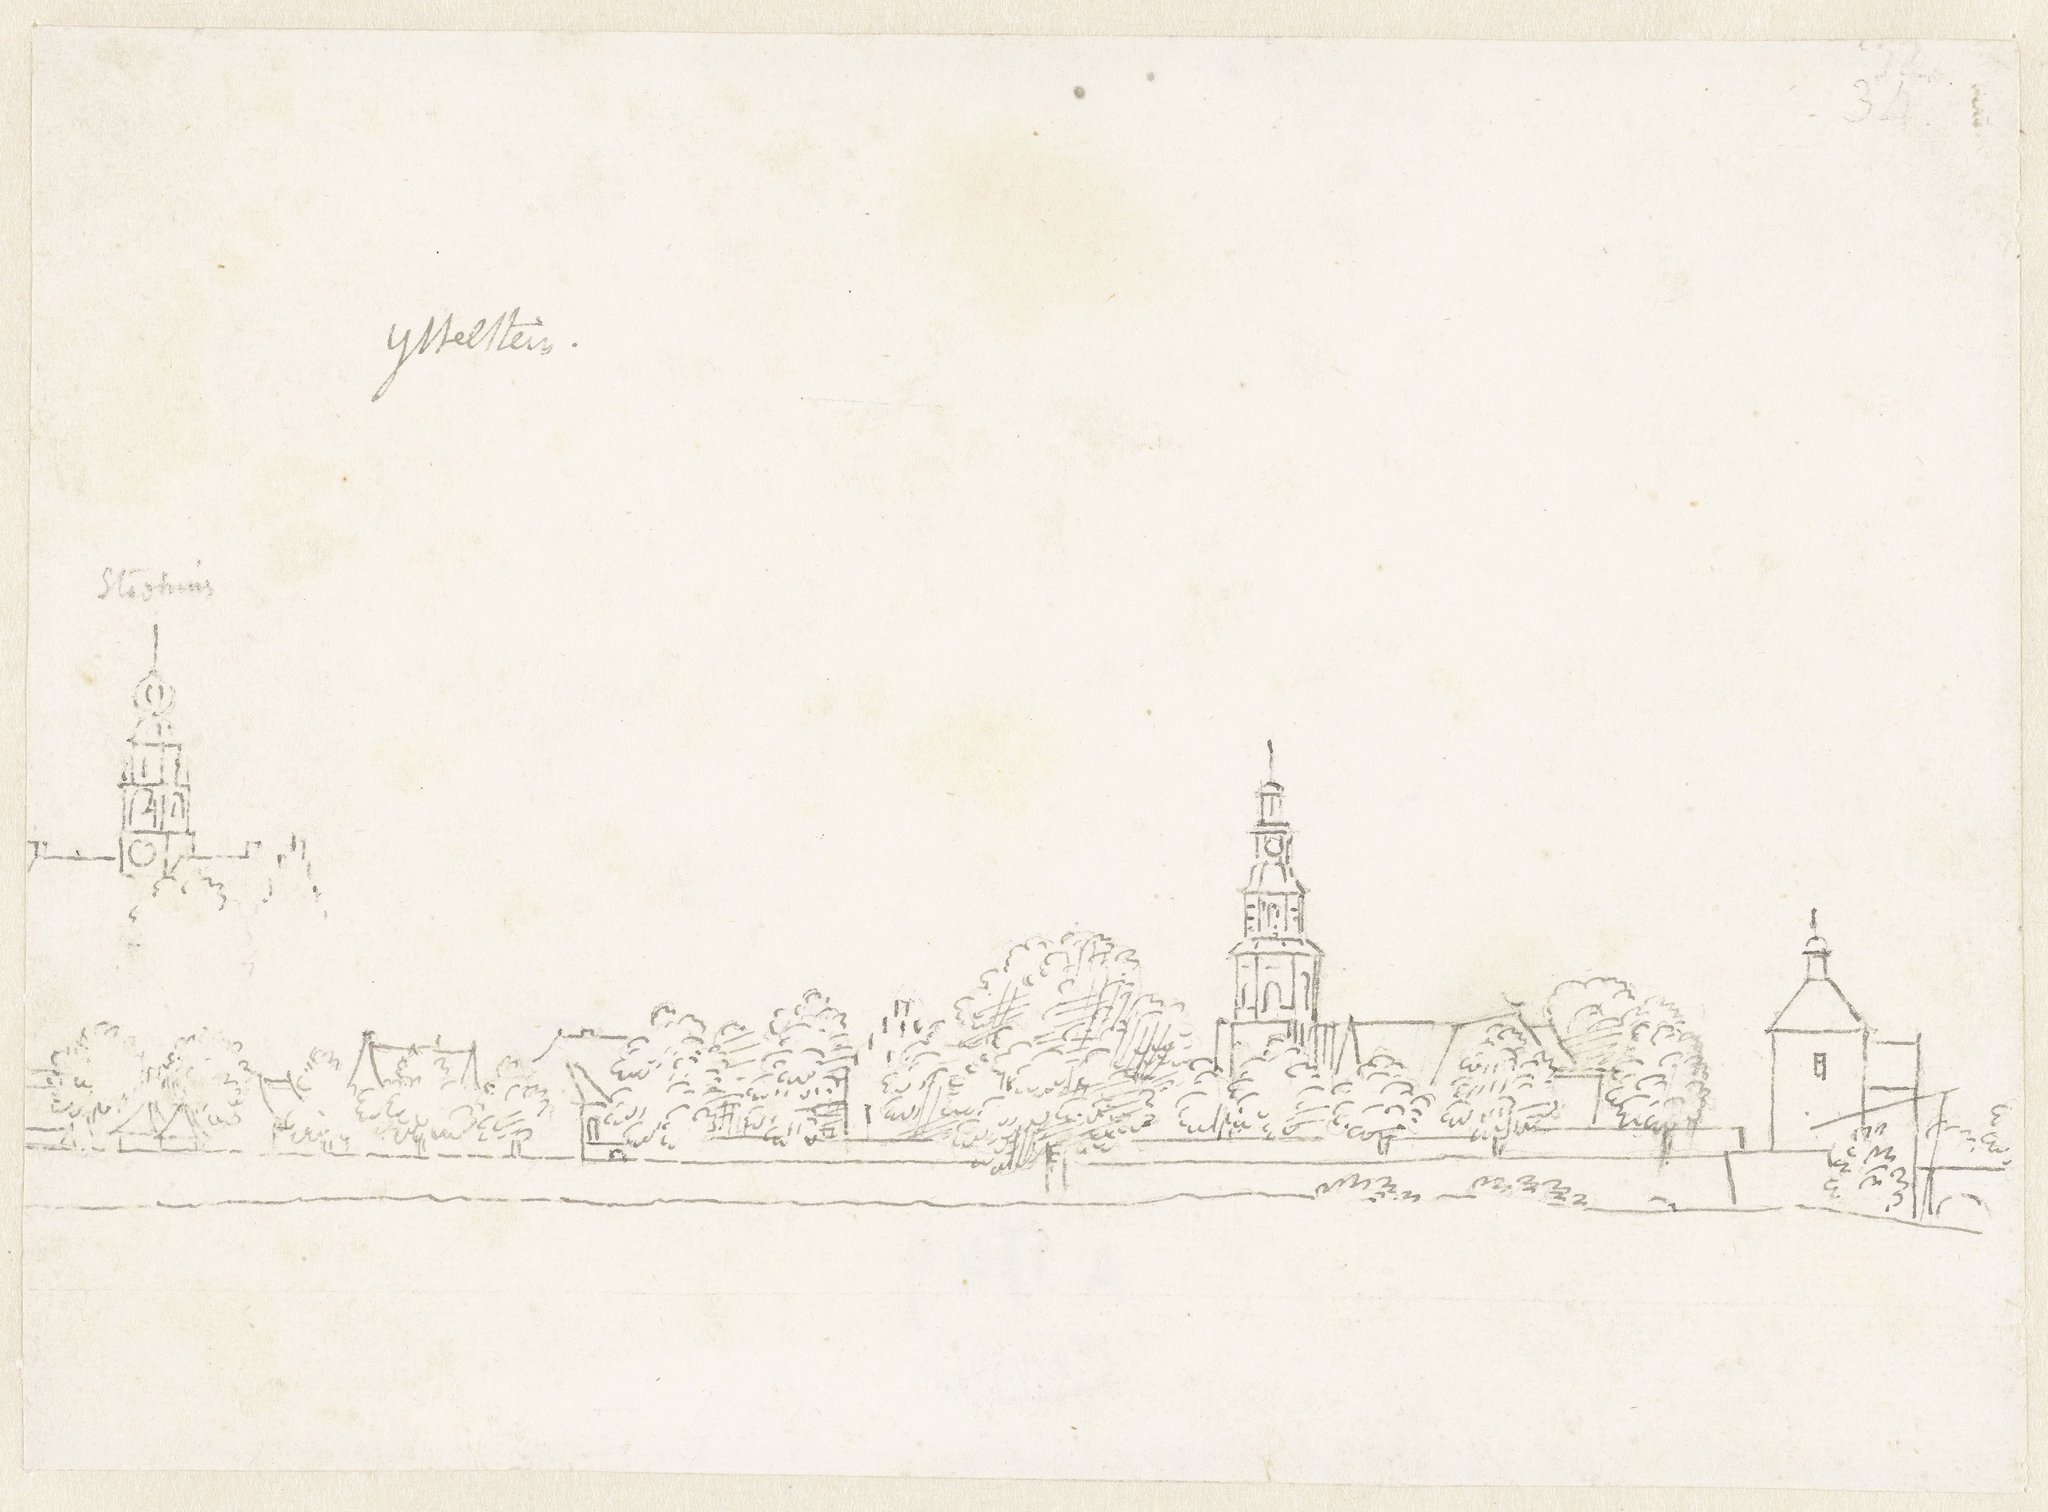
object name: drawing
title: Gezicht op IJsselstein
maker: cornelis pronk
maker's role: draughtsman, painter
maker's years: 1691-1759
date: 1701-1759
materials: ink, paper, pencil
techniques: pen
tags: city-view in general; 'veduta'